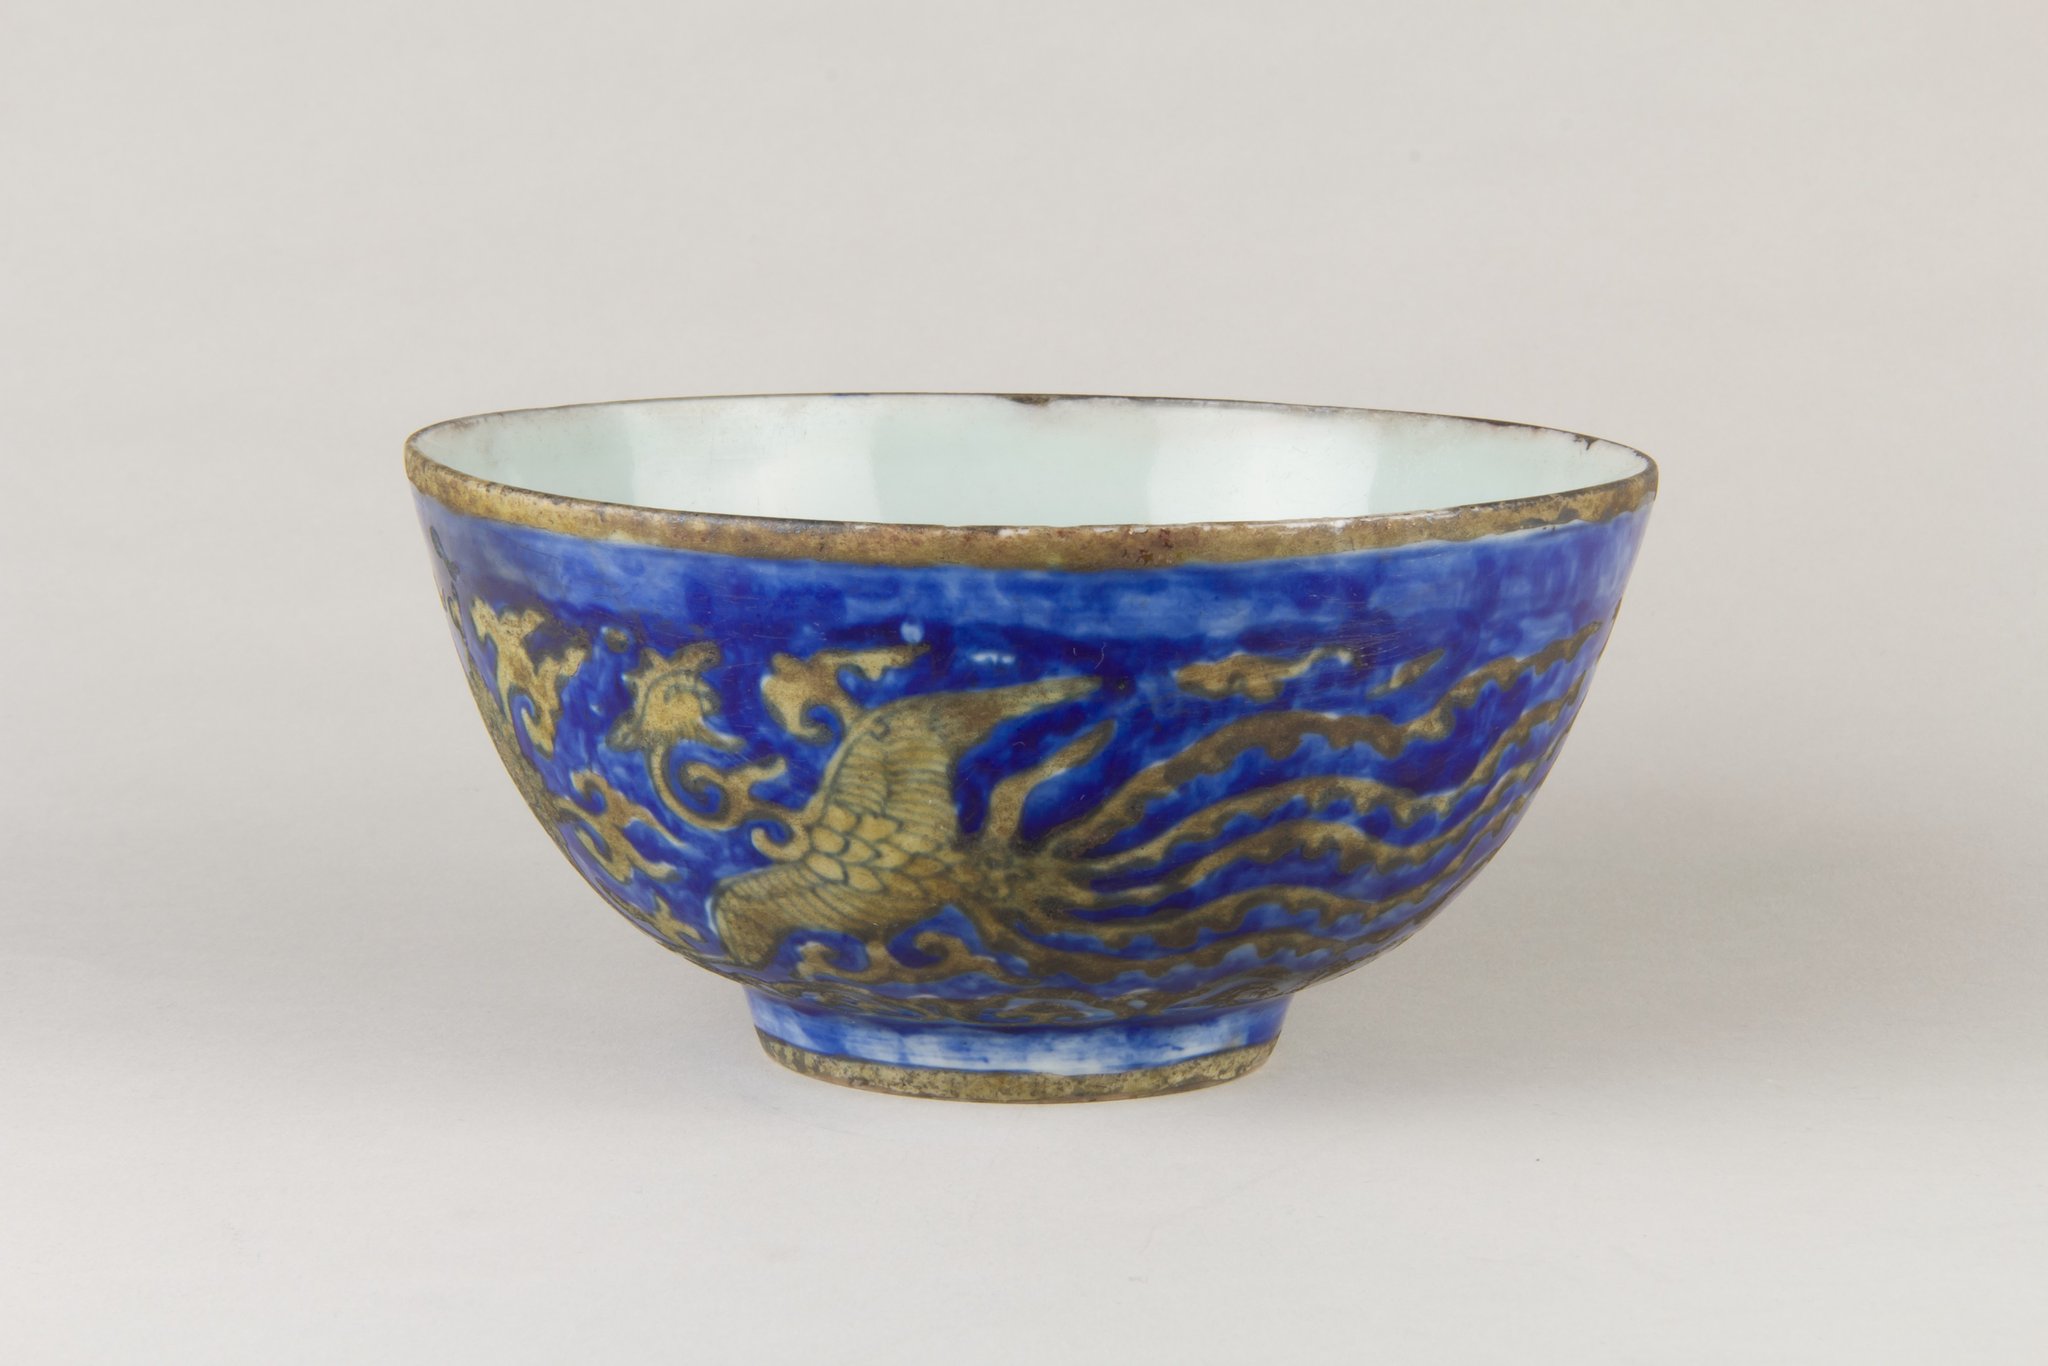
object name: bowl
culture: chinese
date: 1796-1820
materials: enamel, porcelain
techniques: overglaze, painting, underglaze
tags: birds